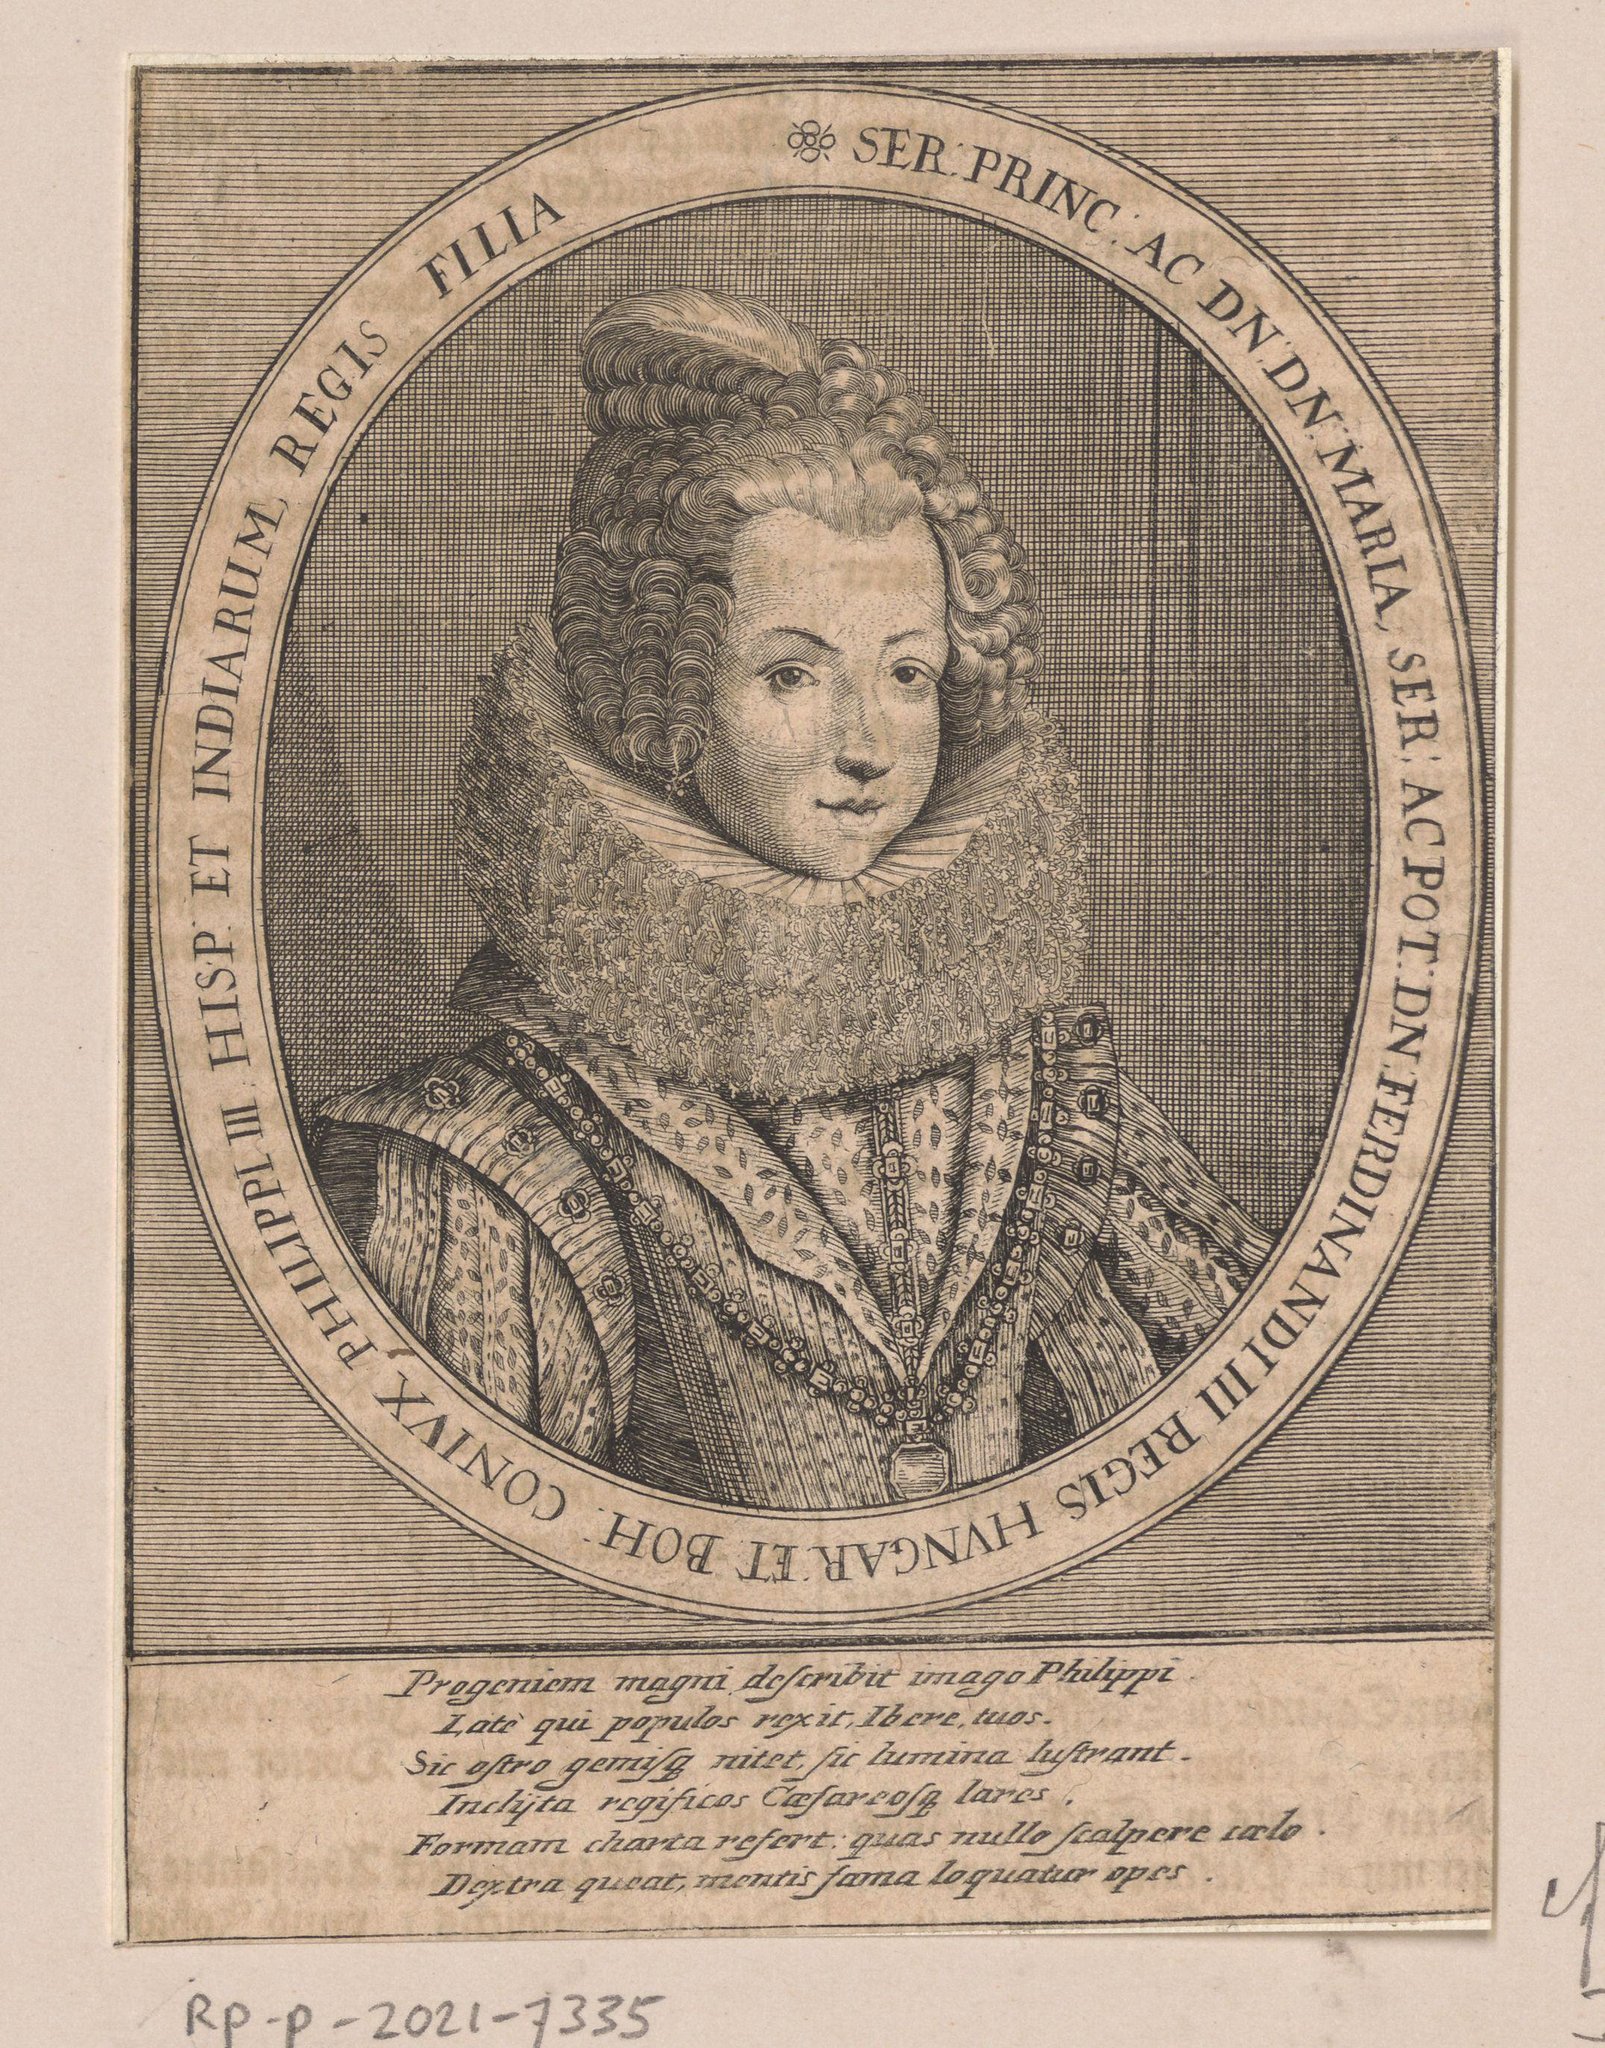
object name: book illustration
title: Portret van Maria Anna van Oostenrijk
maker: Anonymous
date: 1620-1631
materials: paper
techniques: engraving, etching, letterpress printing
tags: historical persons - bb - woman, ornament ~ medallion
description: Met randschrift en zesregelig onderschrift in het Latijn.